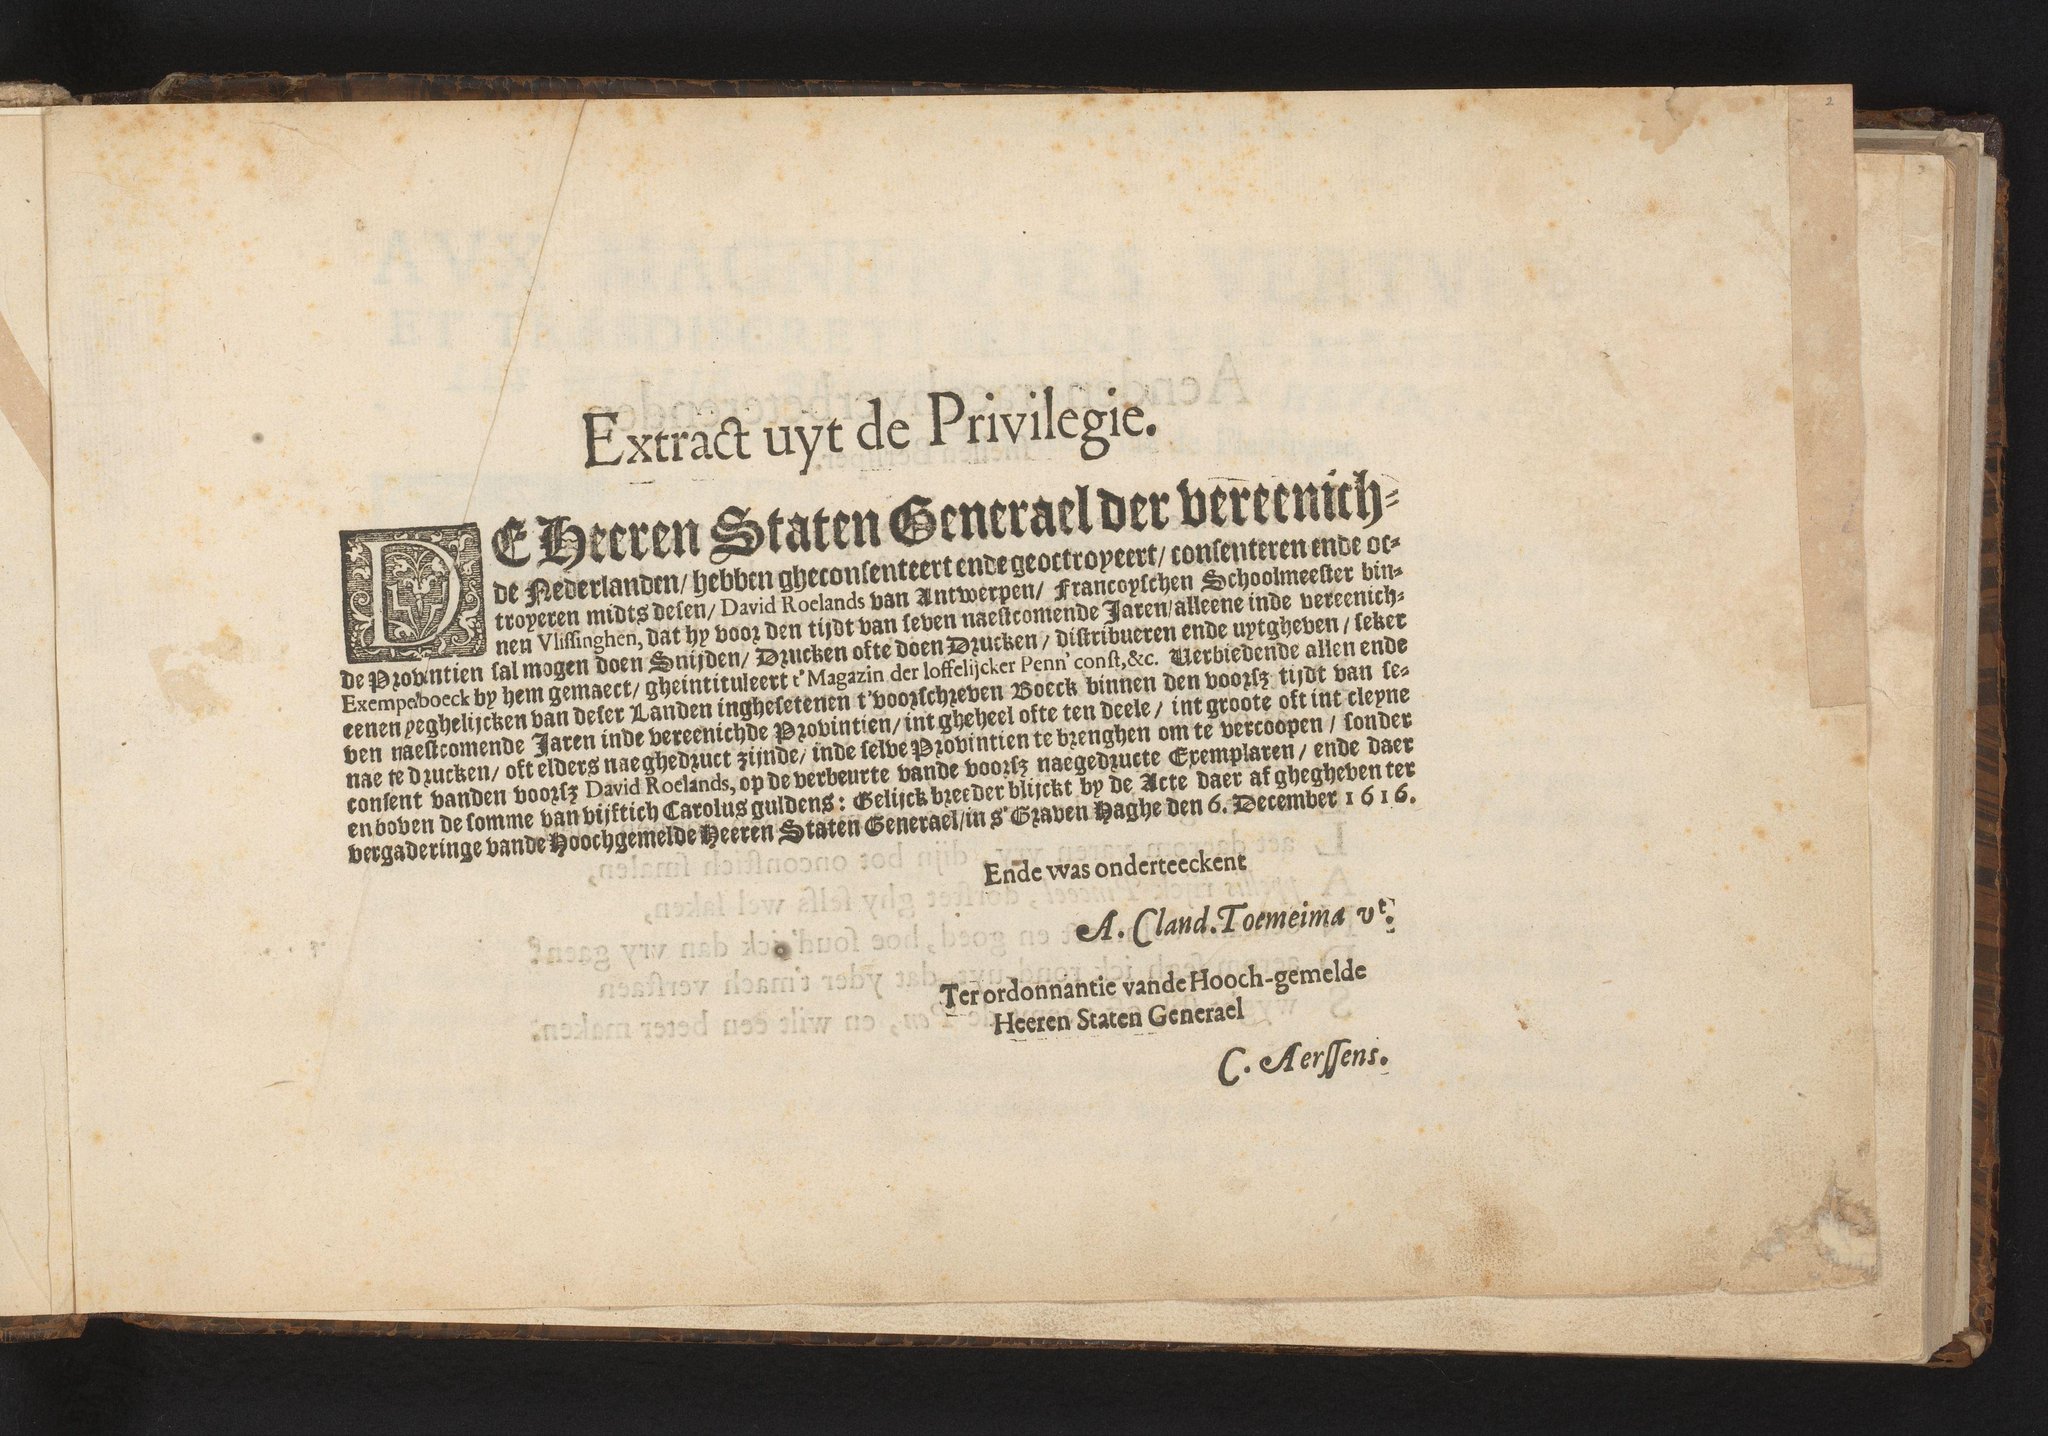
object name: text sheet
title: 't Magazin oft pac-huys der loffelycker penn-const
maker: david roelands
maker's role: kalligraaf, onderwijzer, schoolmeester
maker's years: 1572-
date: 1616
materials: paper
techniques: letterpress printing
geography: the hague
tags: initial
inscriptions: date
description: Tekstblad met een extract uit de tekst van het privilege verleend door de Staten Generaal aan David Roelands voor het boek getiteld: t'Magazin oft pac-huys, gedateerd 6 december 1616. De tekst begint met een gedecoreerde initiaal D. Het tekstblad maakt deel uit van een album.